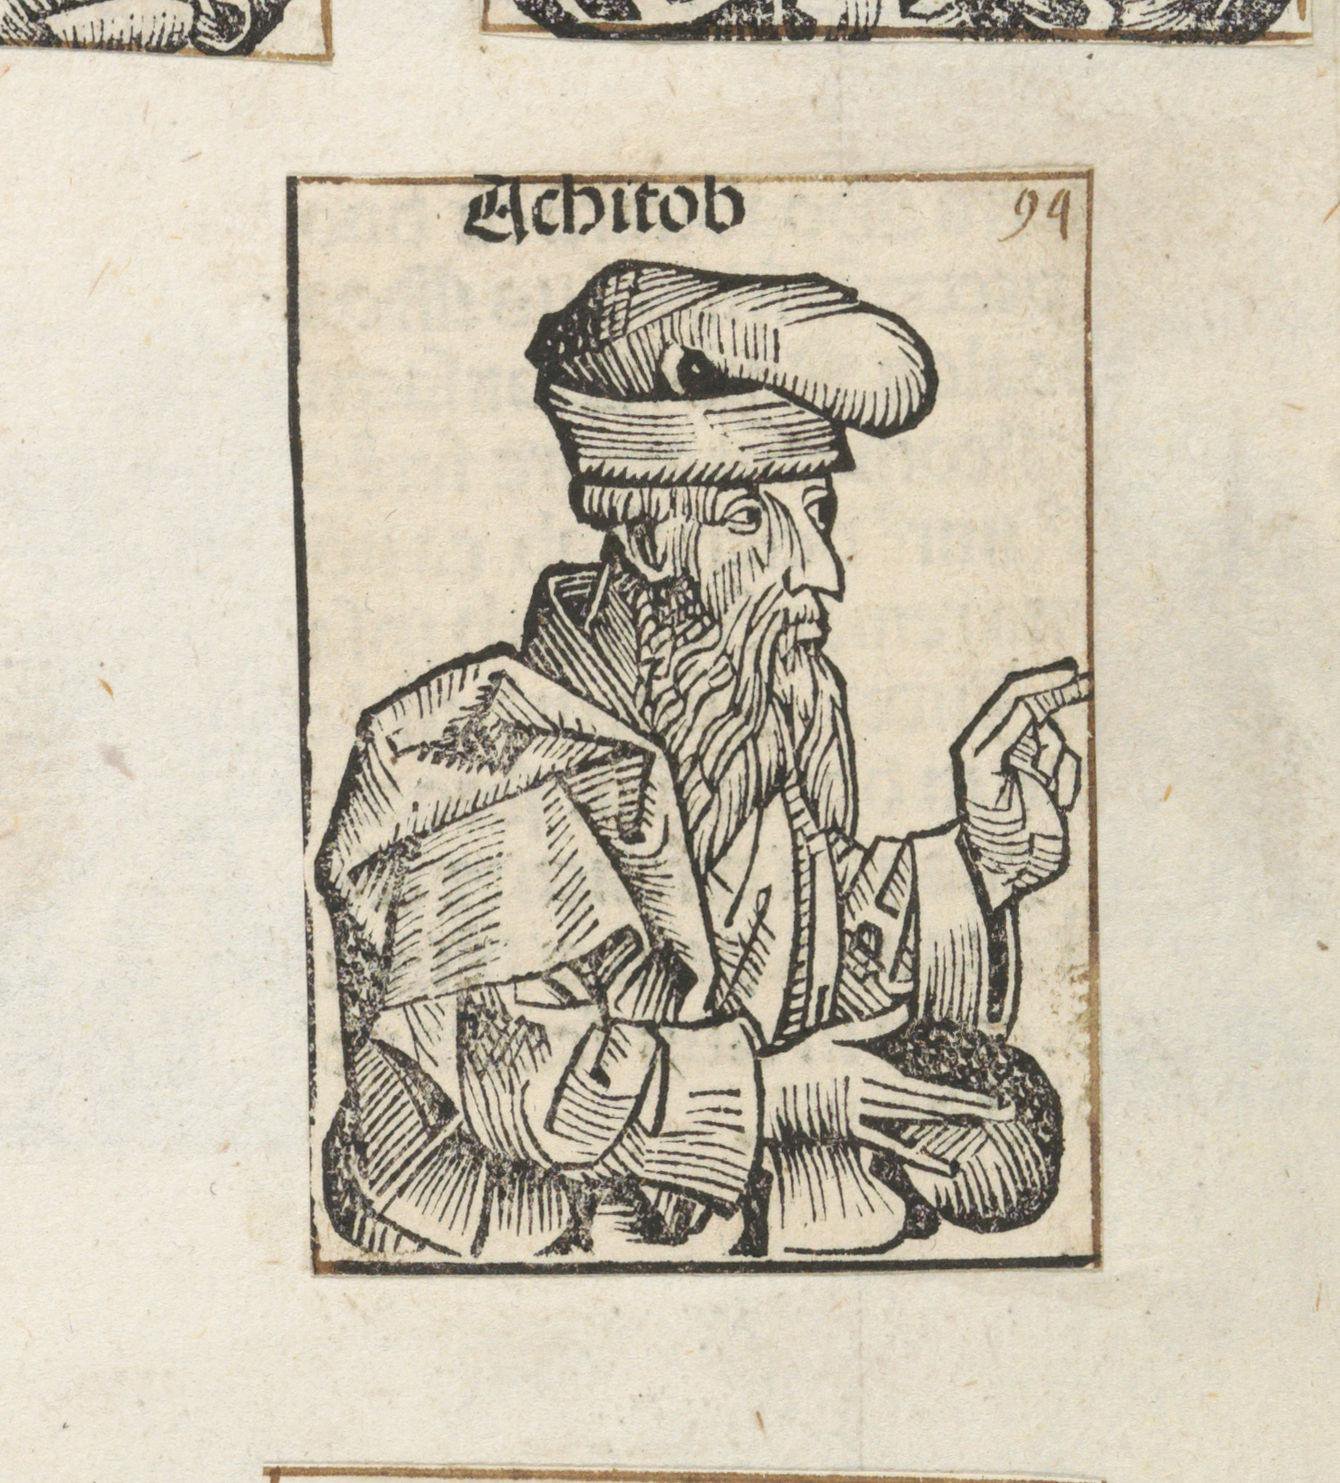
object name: print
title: Achitub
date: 1493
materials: paper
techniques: letterpress printing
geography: nuremberg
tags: persons from the old testament (not in biblical context, nor occurring in legendary/historical extensions included in division 71)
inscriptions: inscription: ‘94’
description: De houtsnede wordt gebruikt als boekillustratie in de Liber Chronicarum (of Neurenbergkroniek) van Hartmann Schedel, verschenen in het Latijn en Duits in 1493. Zie de Latijnse uitgave, folio 40v.